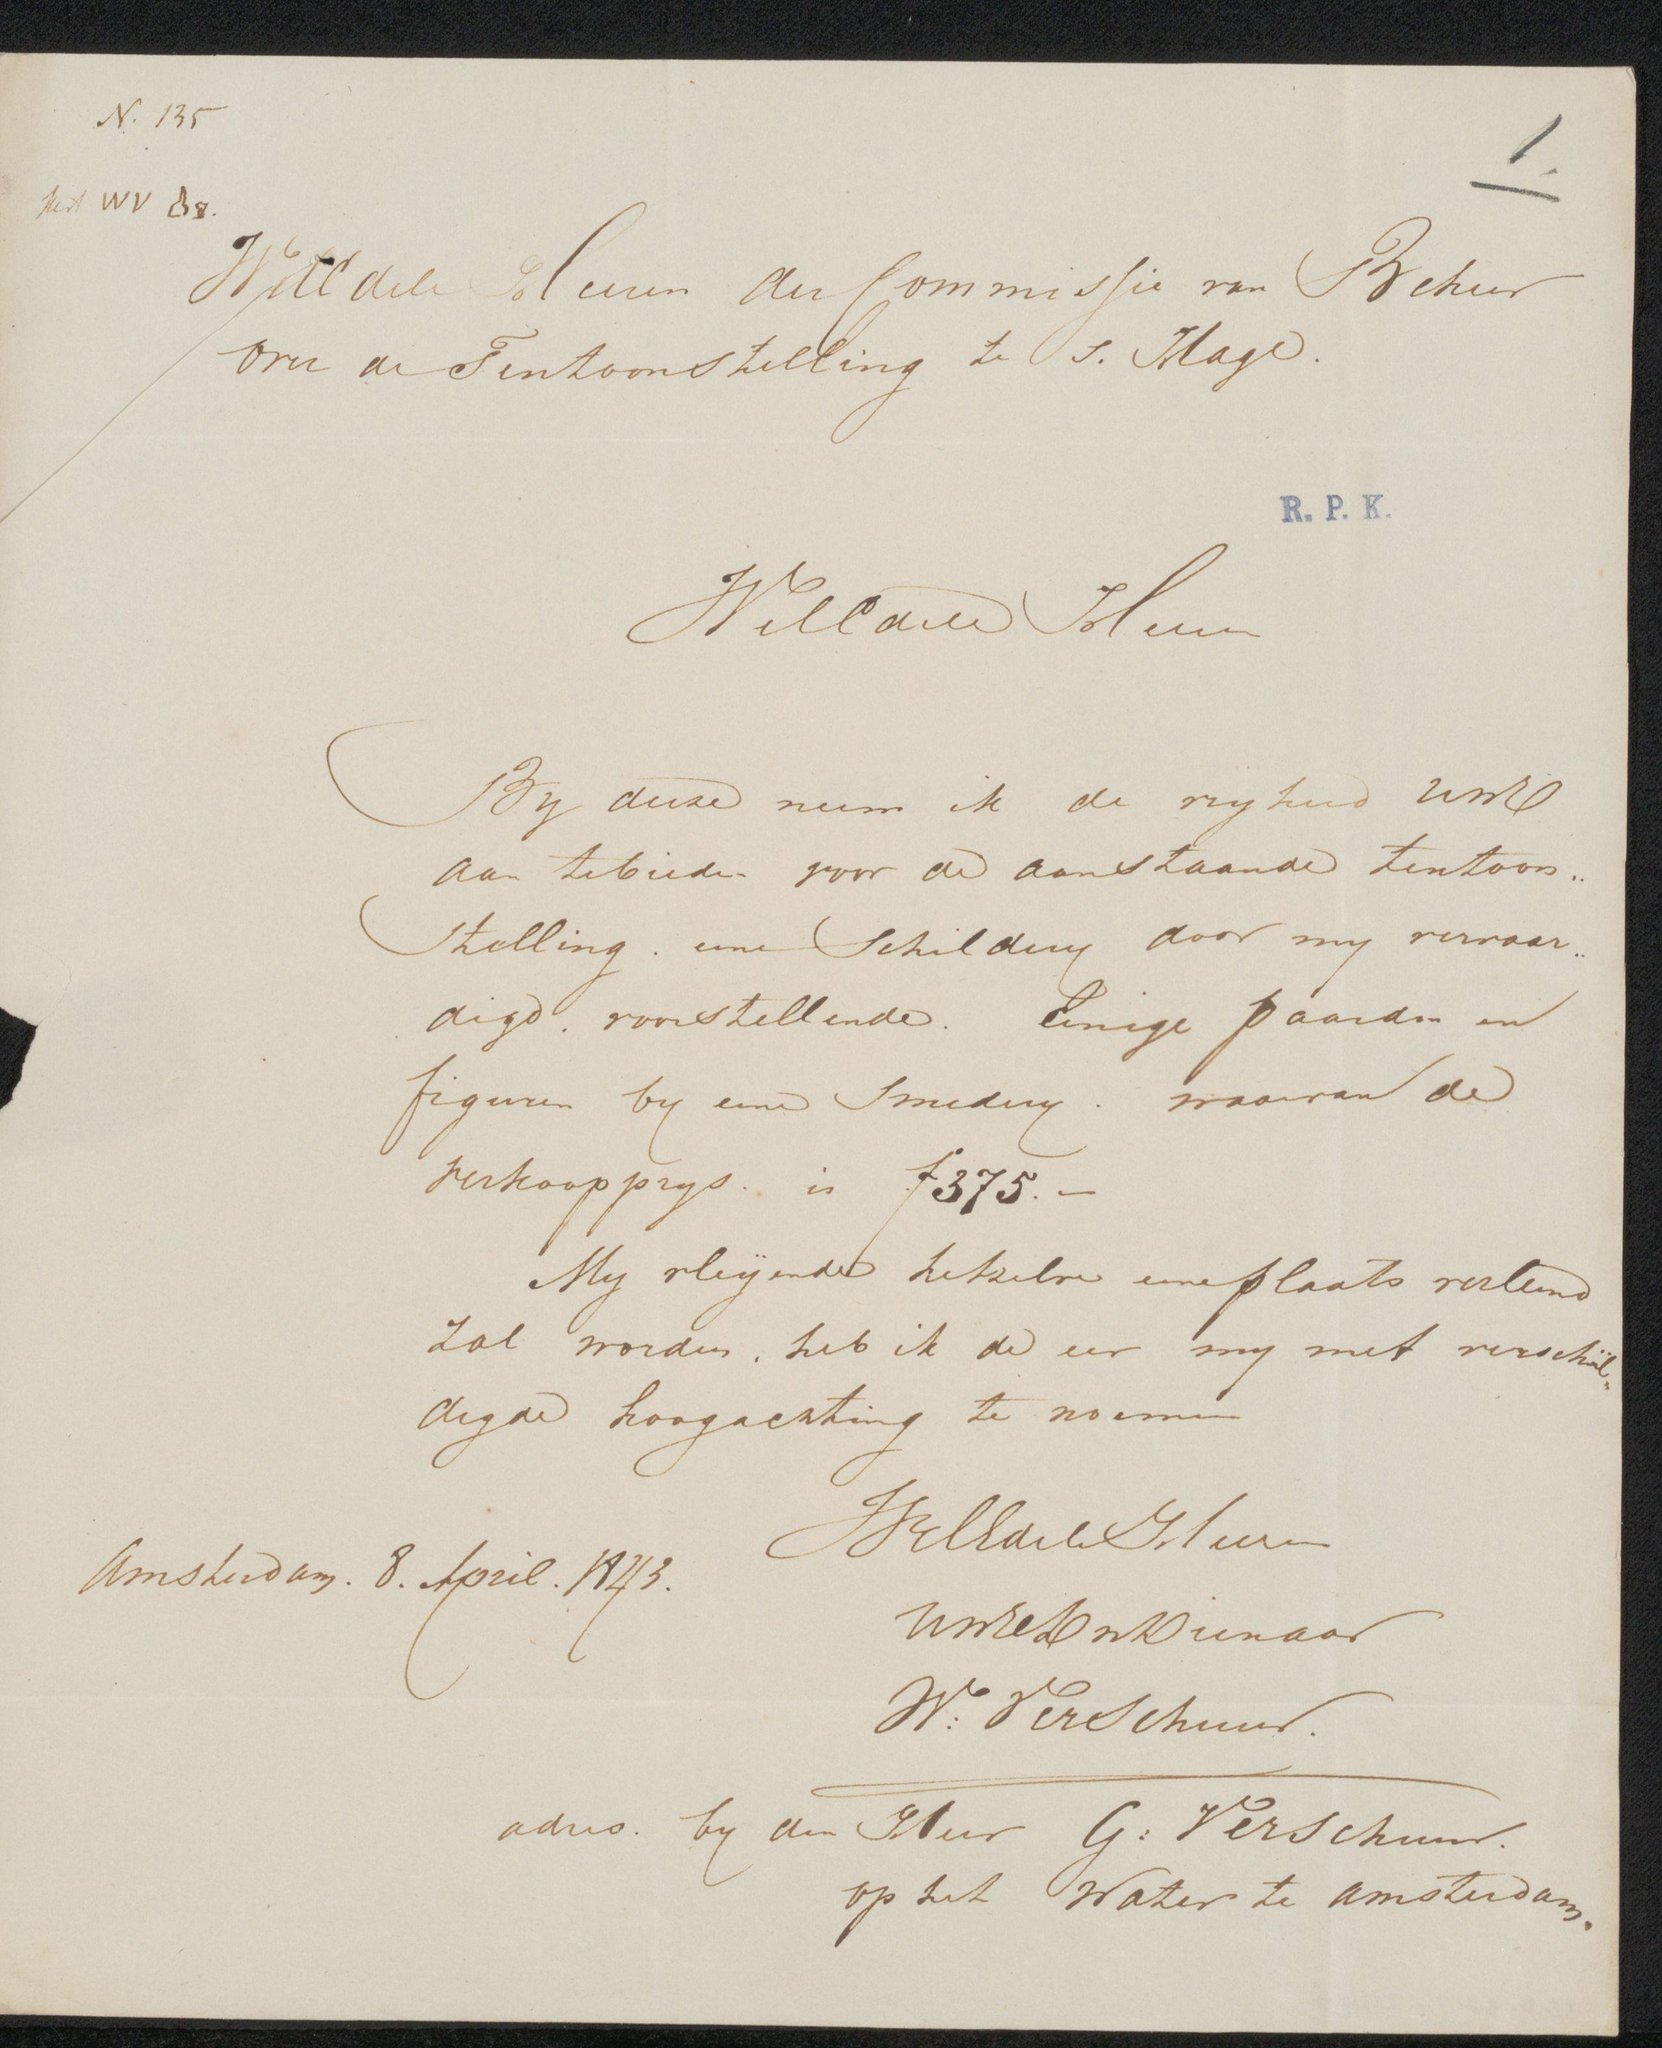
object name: letter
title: Brief aan de commissie van de Tentoonstelling van Levende Meesters in Den Haag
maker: wouter verschuur (1812-1874)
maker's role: draughtsman, painter, print maker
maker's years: 1812-1874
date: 1843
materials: ink, paper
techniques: pen, writing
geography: amsterdam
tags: painting (including book-illumination, miniature-painting), exhibition ~ art, money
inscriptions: collector's mark: Lugt 2233